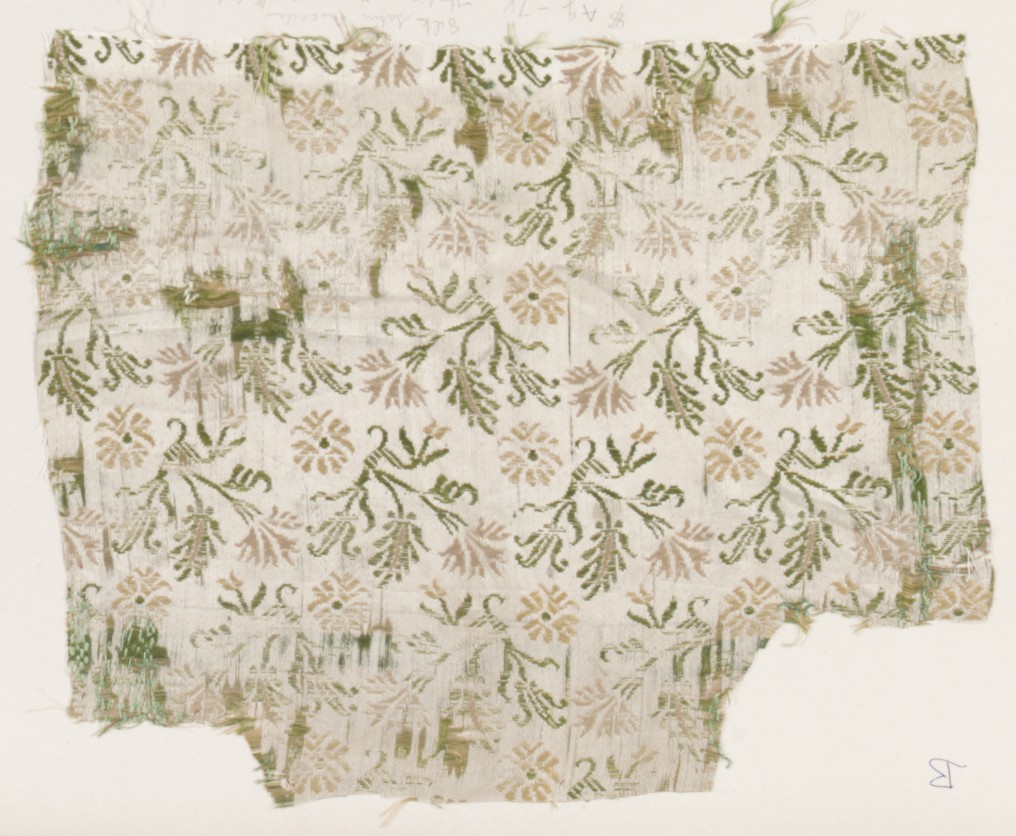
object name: fragment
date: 1601-1633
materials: silk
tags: flowers,leaves